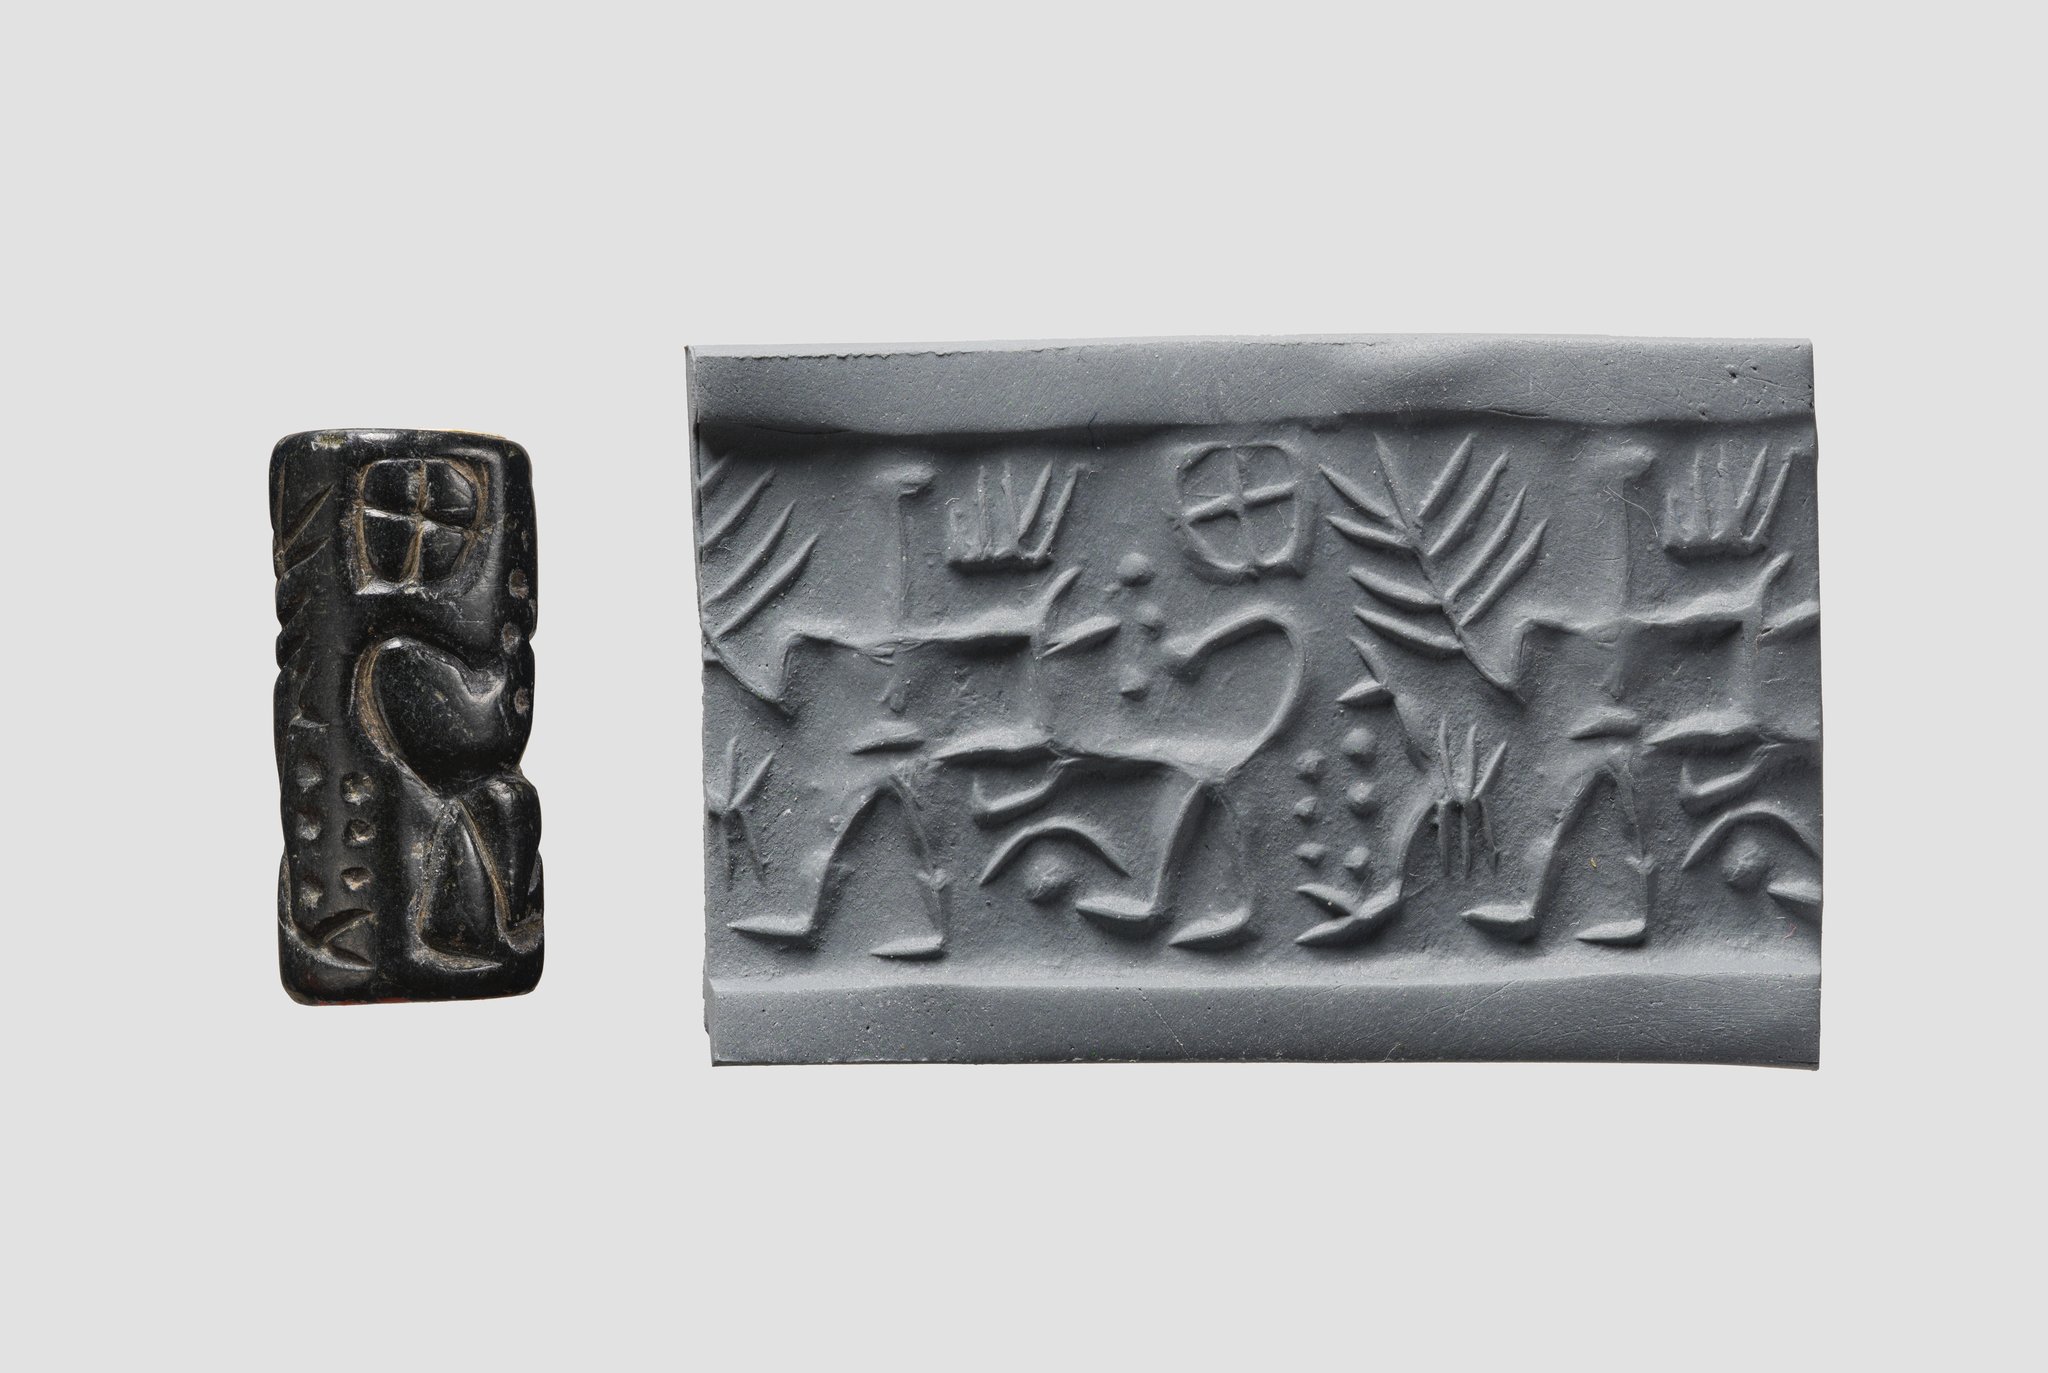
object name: cylinder seal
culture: cypriot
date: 1300-1201 BCE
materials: mineral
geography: cyprus